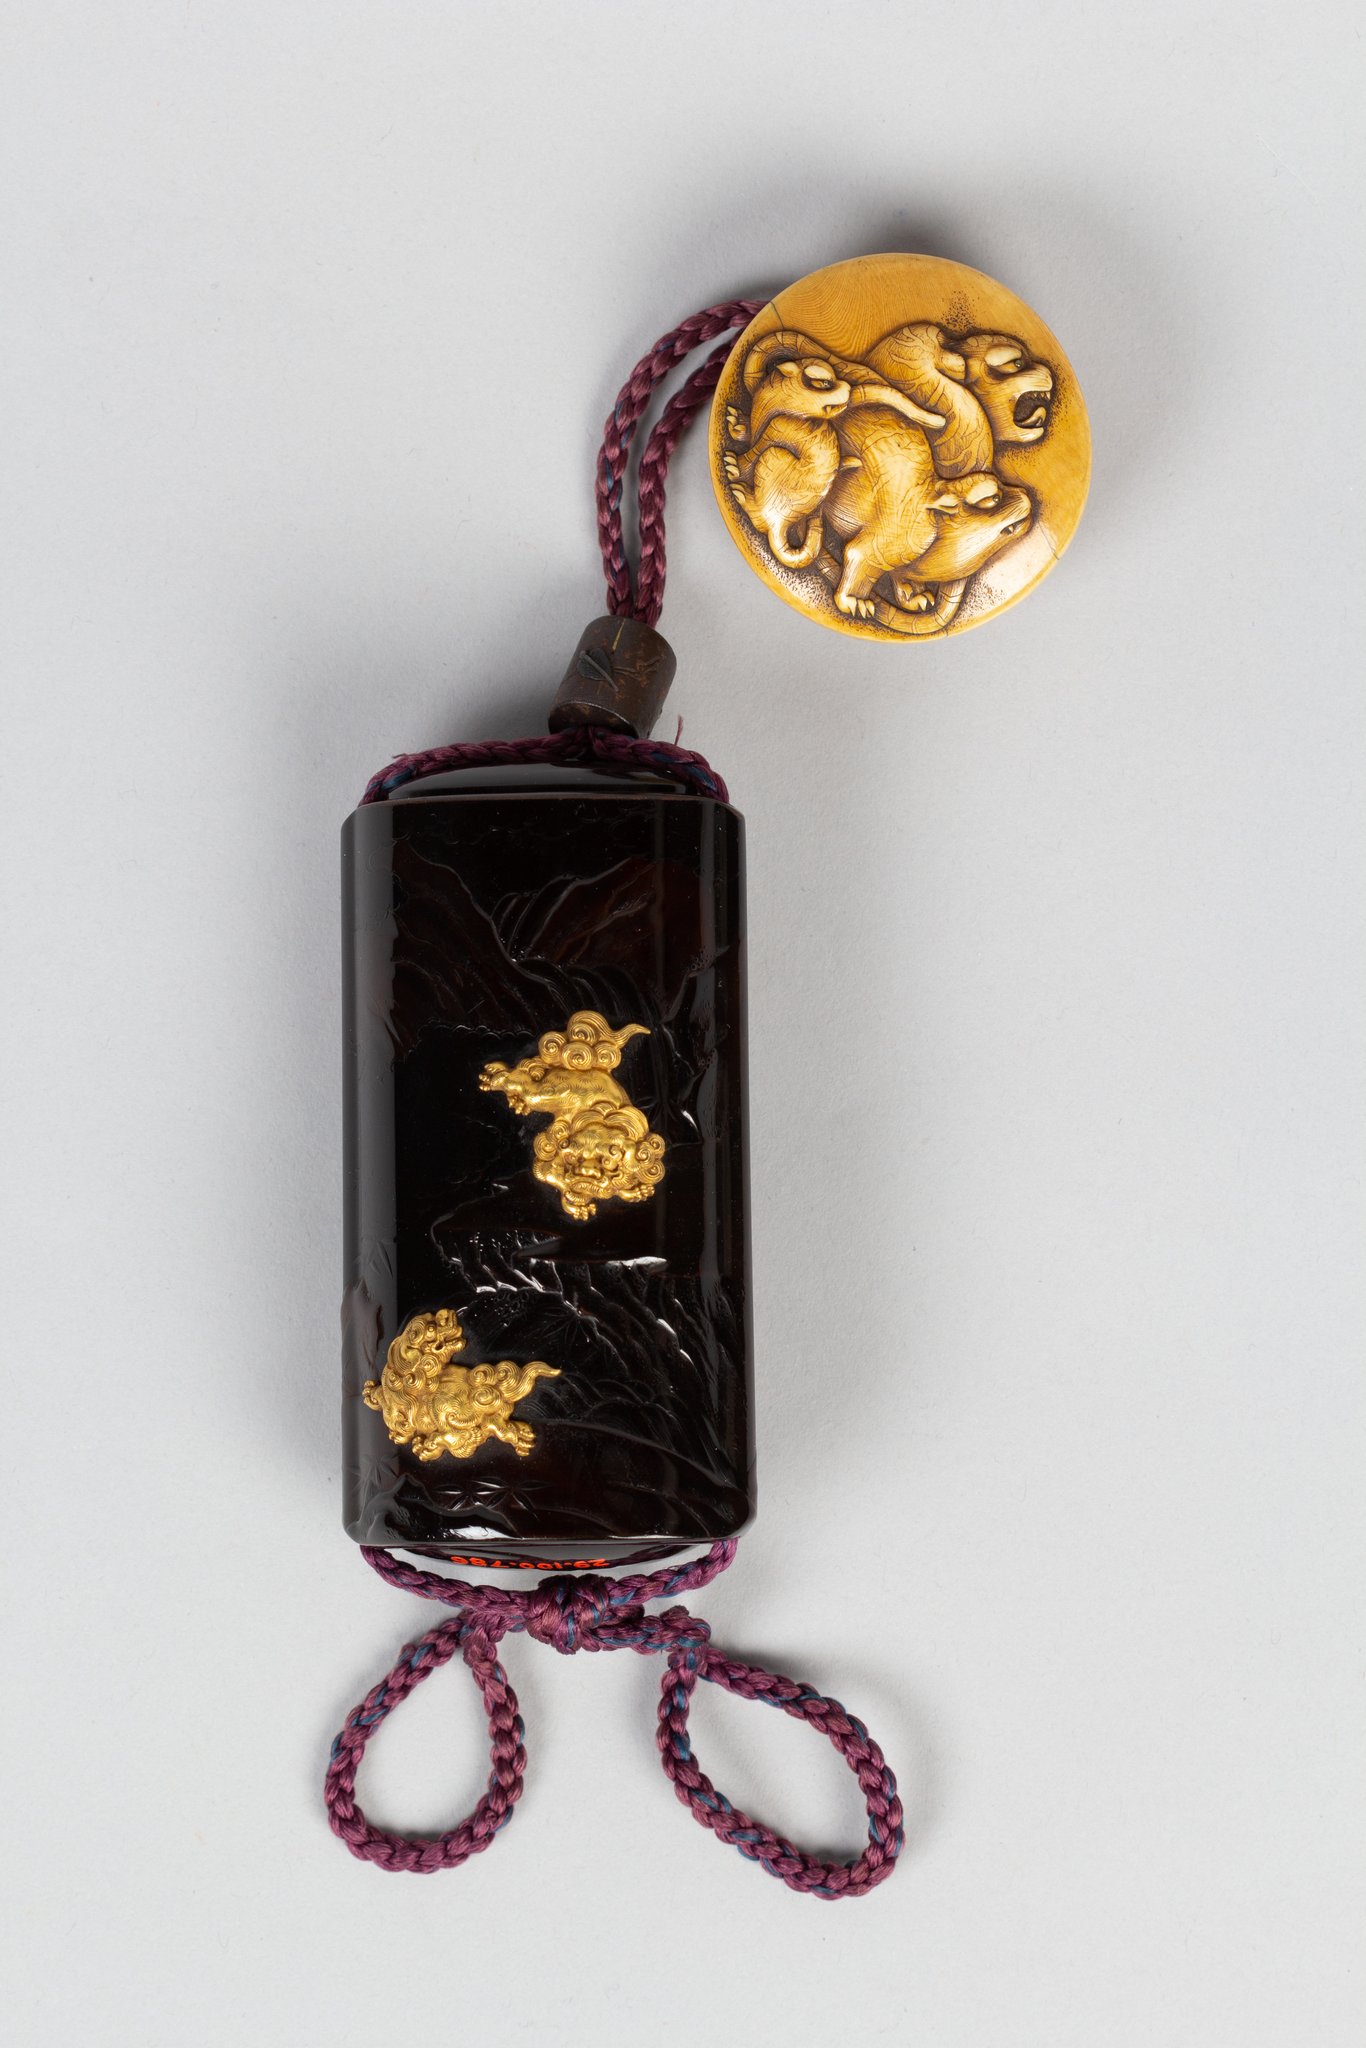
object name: inrō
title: Case (Inrō) with Design of Shishi Dogs beside Rocks and Waterfall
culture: japanese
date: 1701-1900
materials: gold, lacquer, metal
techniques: fundame, hiramakie, inlay, roiro, maki-e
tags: dogs,waterfalls